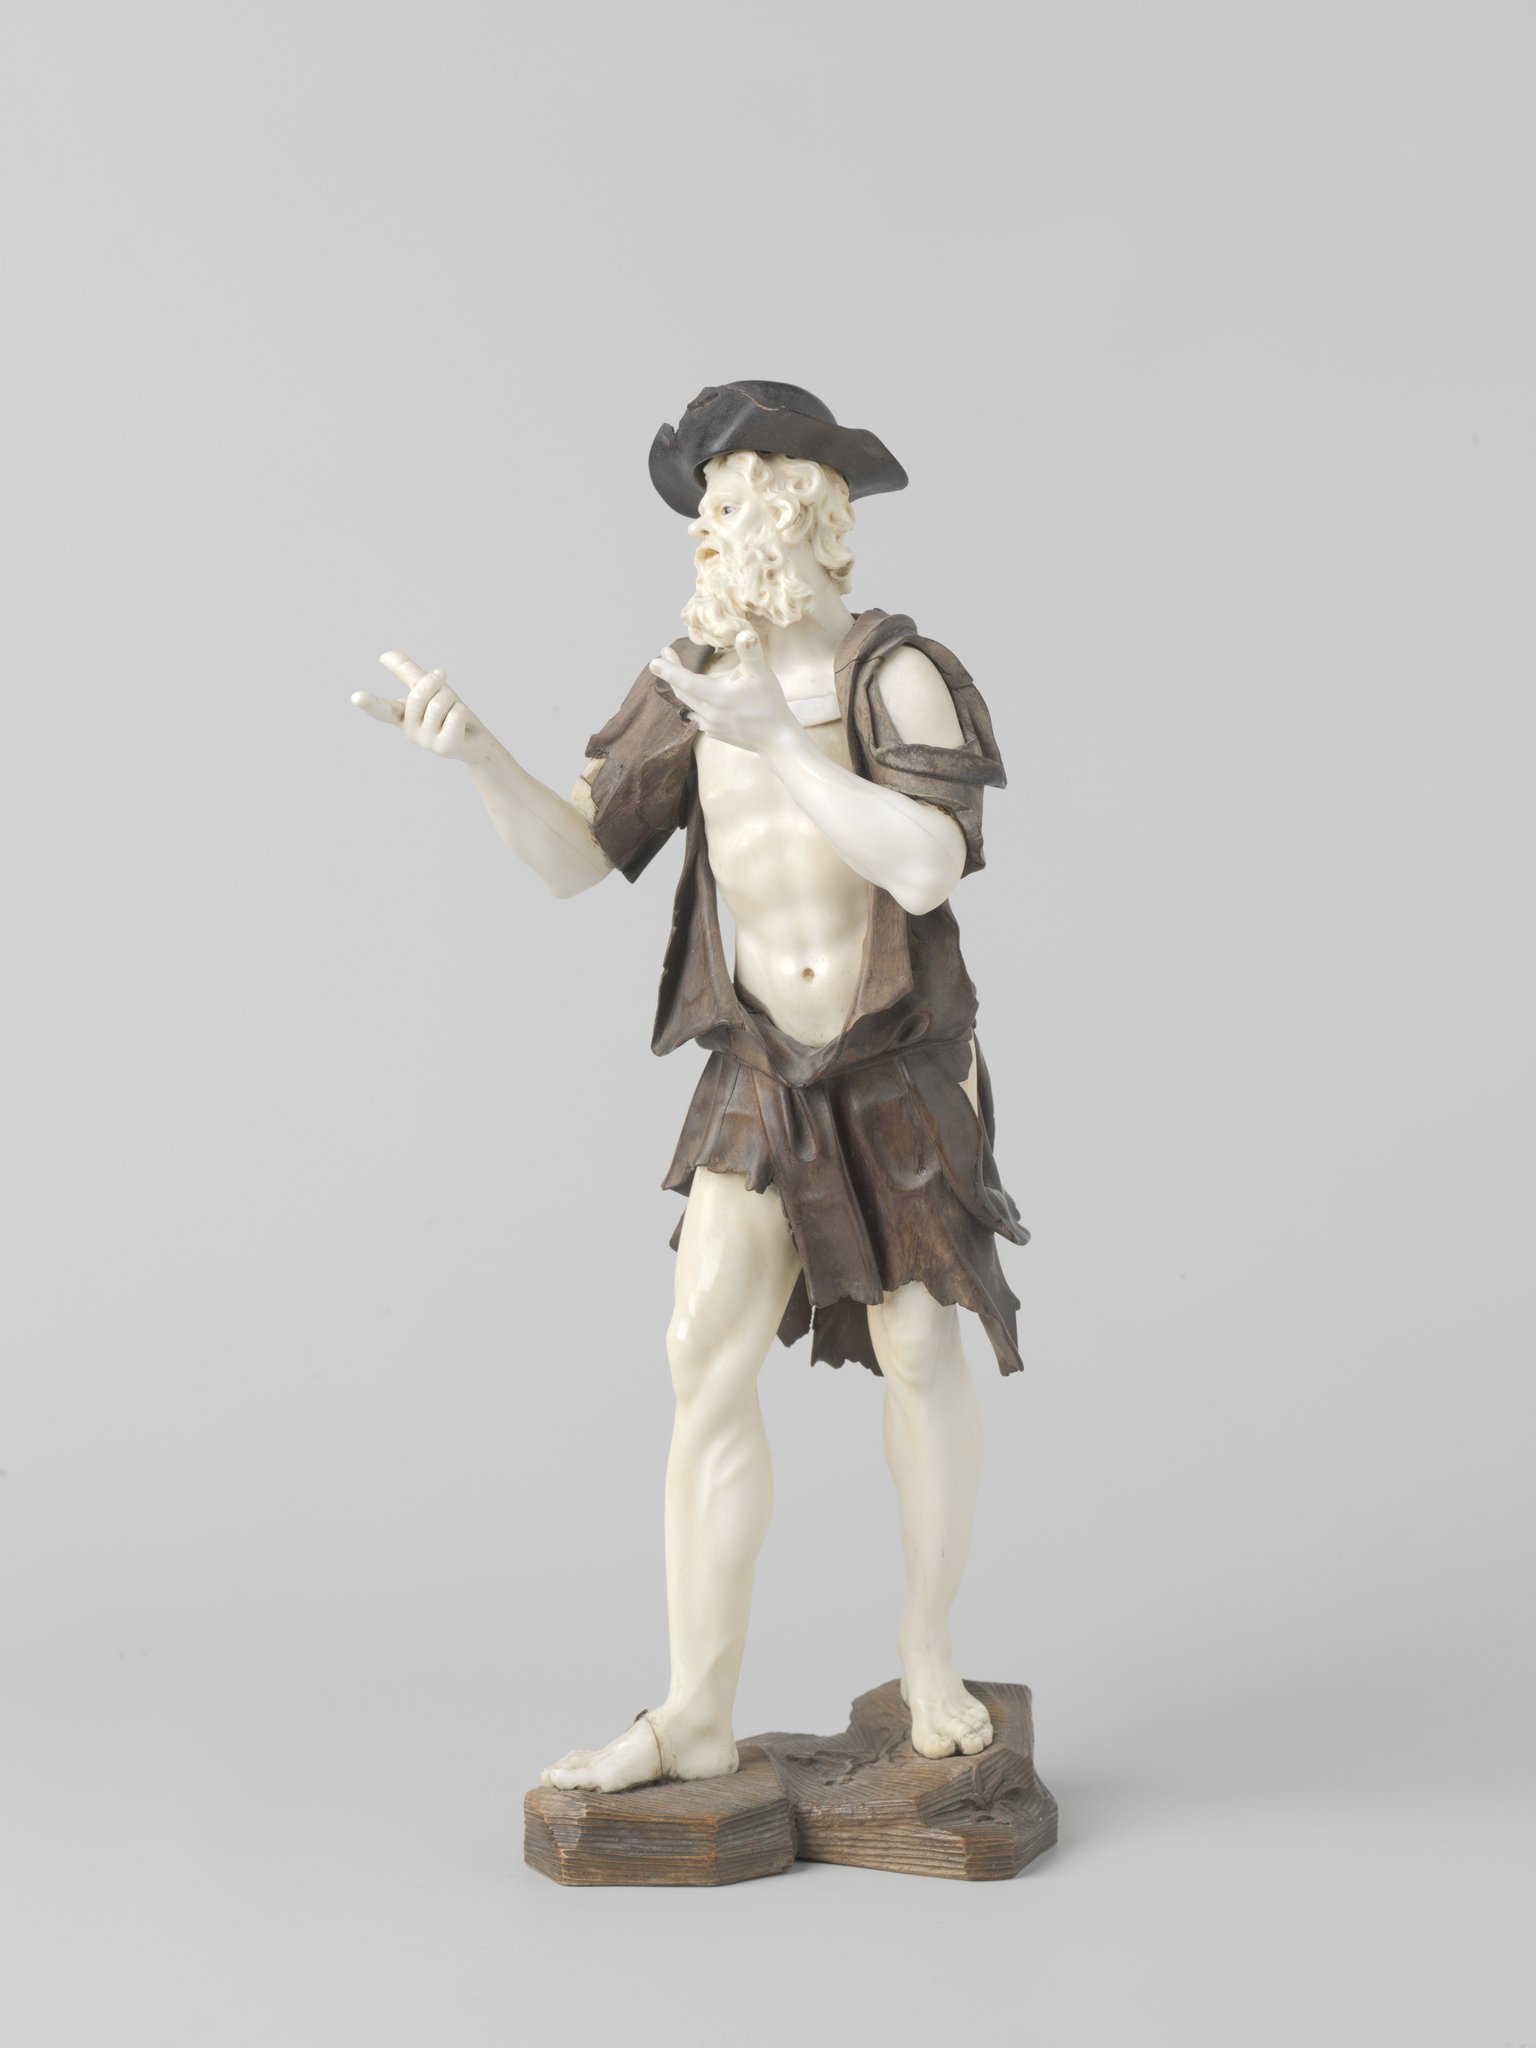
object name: sculpture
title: Bedelaar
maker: simon troger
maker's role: sculptor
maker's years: 1693-1768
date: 1740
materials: glass, ivory, wood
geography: munich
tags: beggar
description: Simon Troger (1693 - 1768), studio. Two beggars, ivory and fruitwood, glass eyes. Munich, c. 1740.